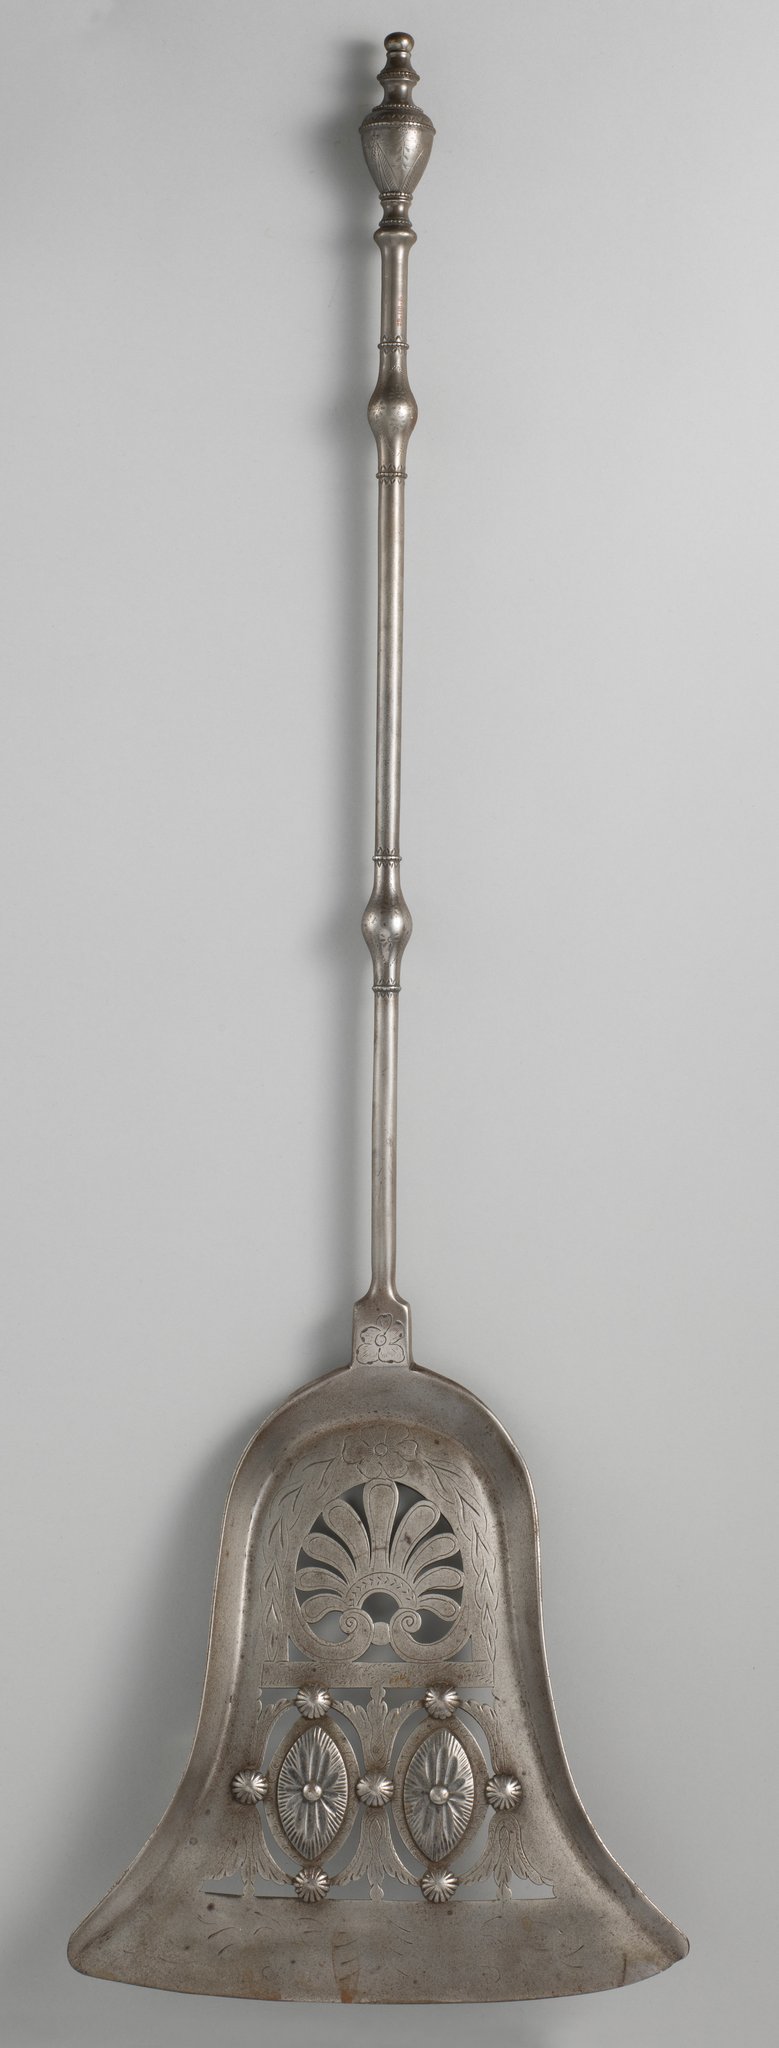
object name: fire iron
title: Fire irons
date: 1770-1780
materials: steel